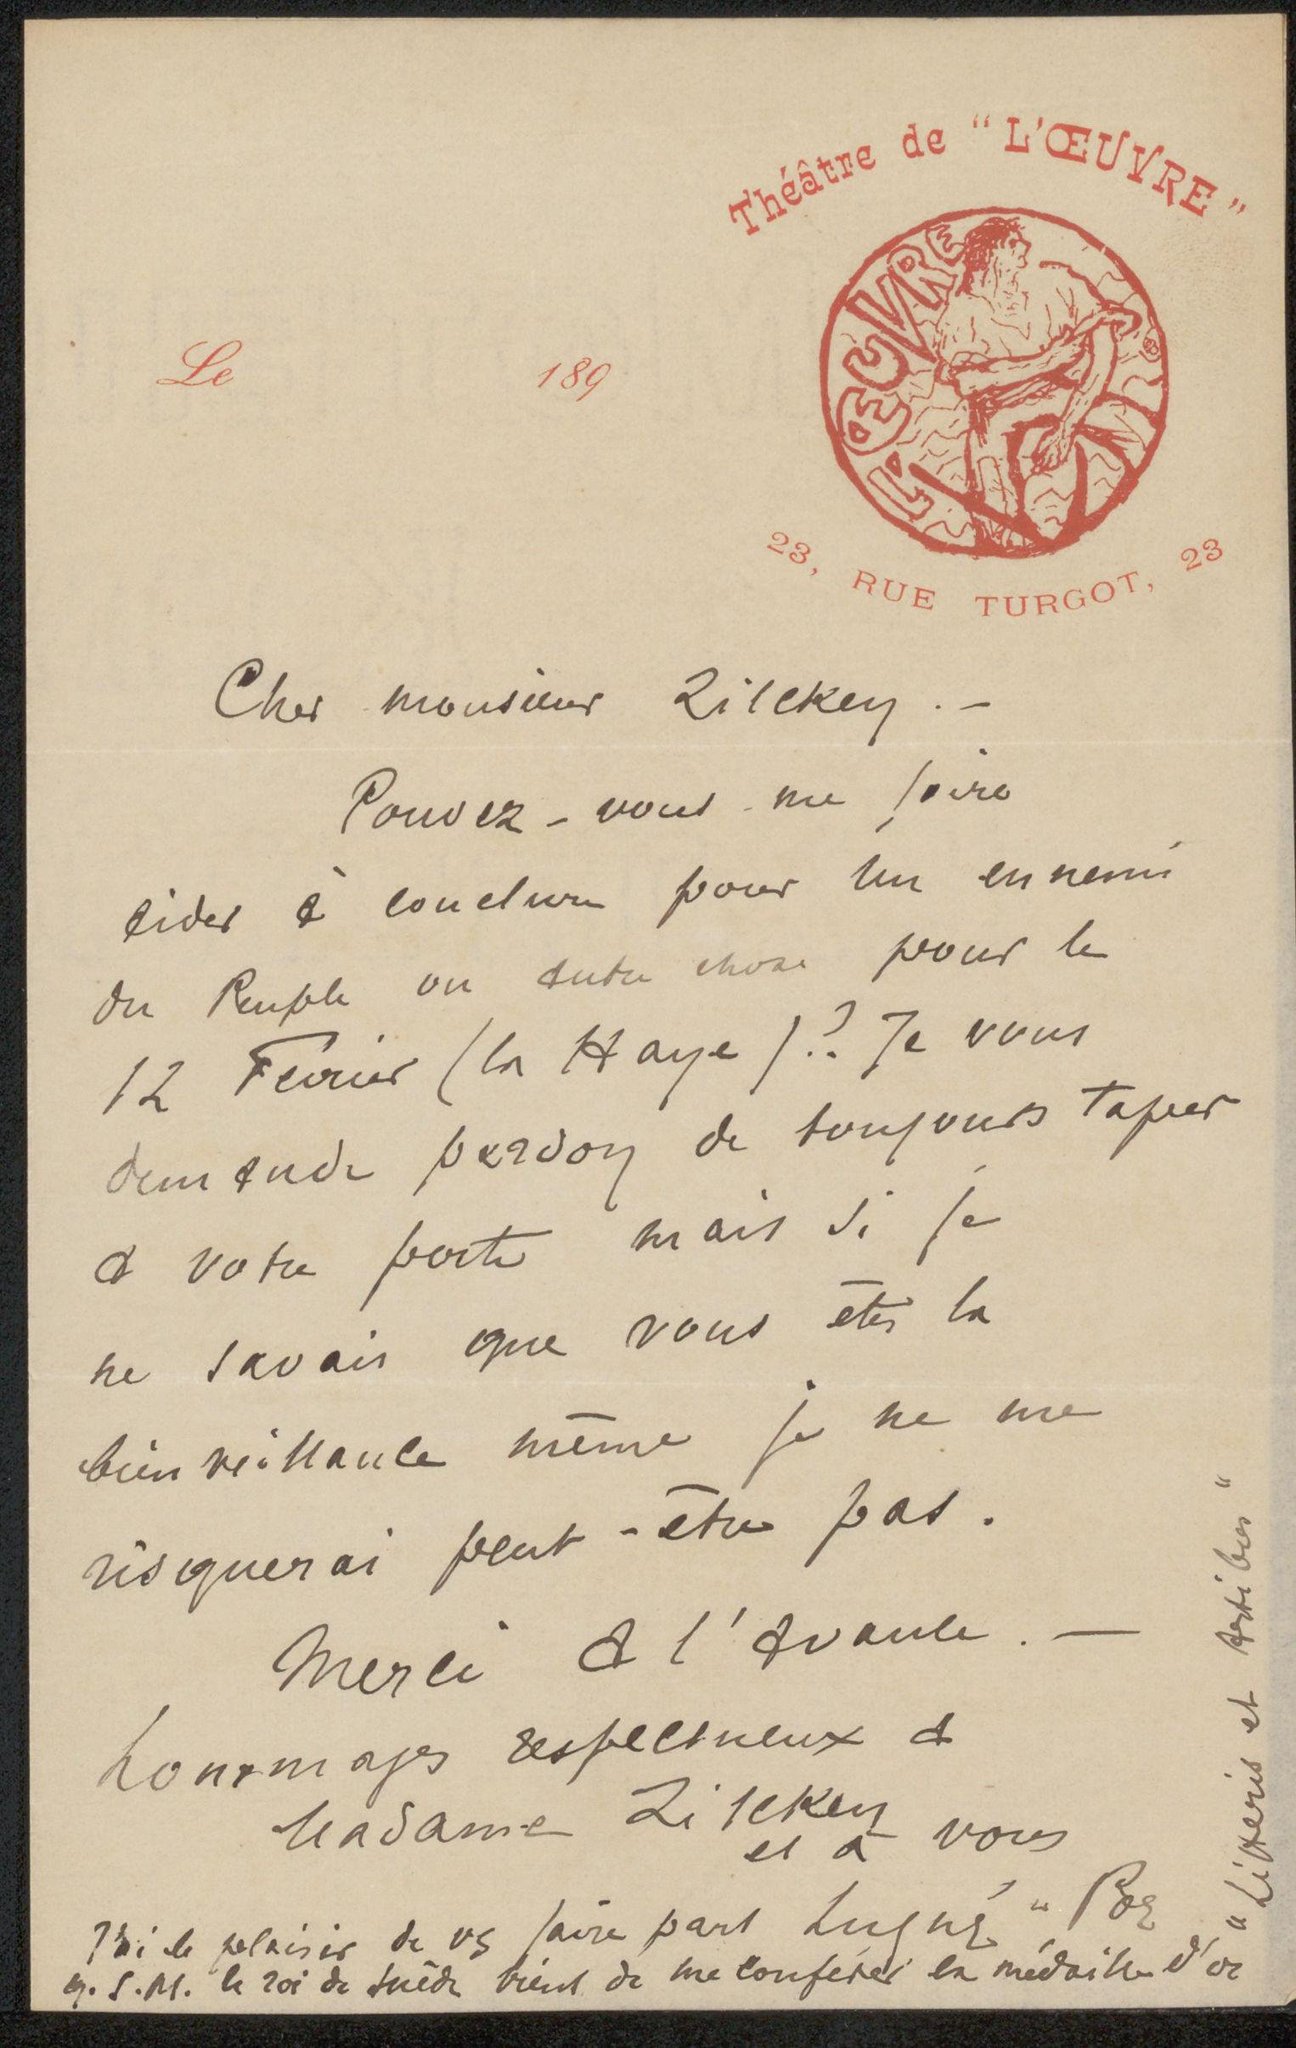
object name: letter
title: Brief aan Philip Zilcken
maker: lugné-poe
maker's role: acteur, theaterdirecteur, theatervormgever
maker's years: 1869-1940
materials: ink, paper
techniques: pen, printing, writing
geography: paris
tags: painter, draughtsman, philip zilcken, the hague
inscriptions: collector's mark: ‘RPK’, watermark